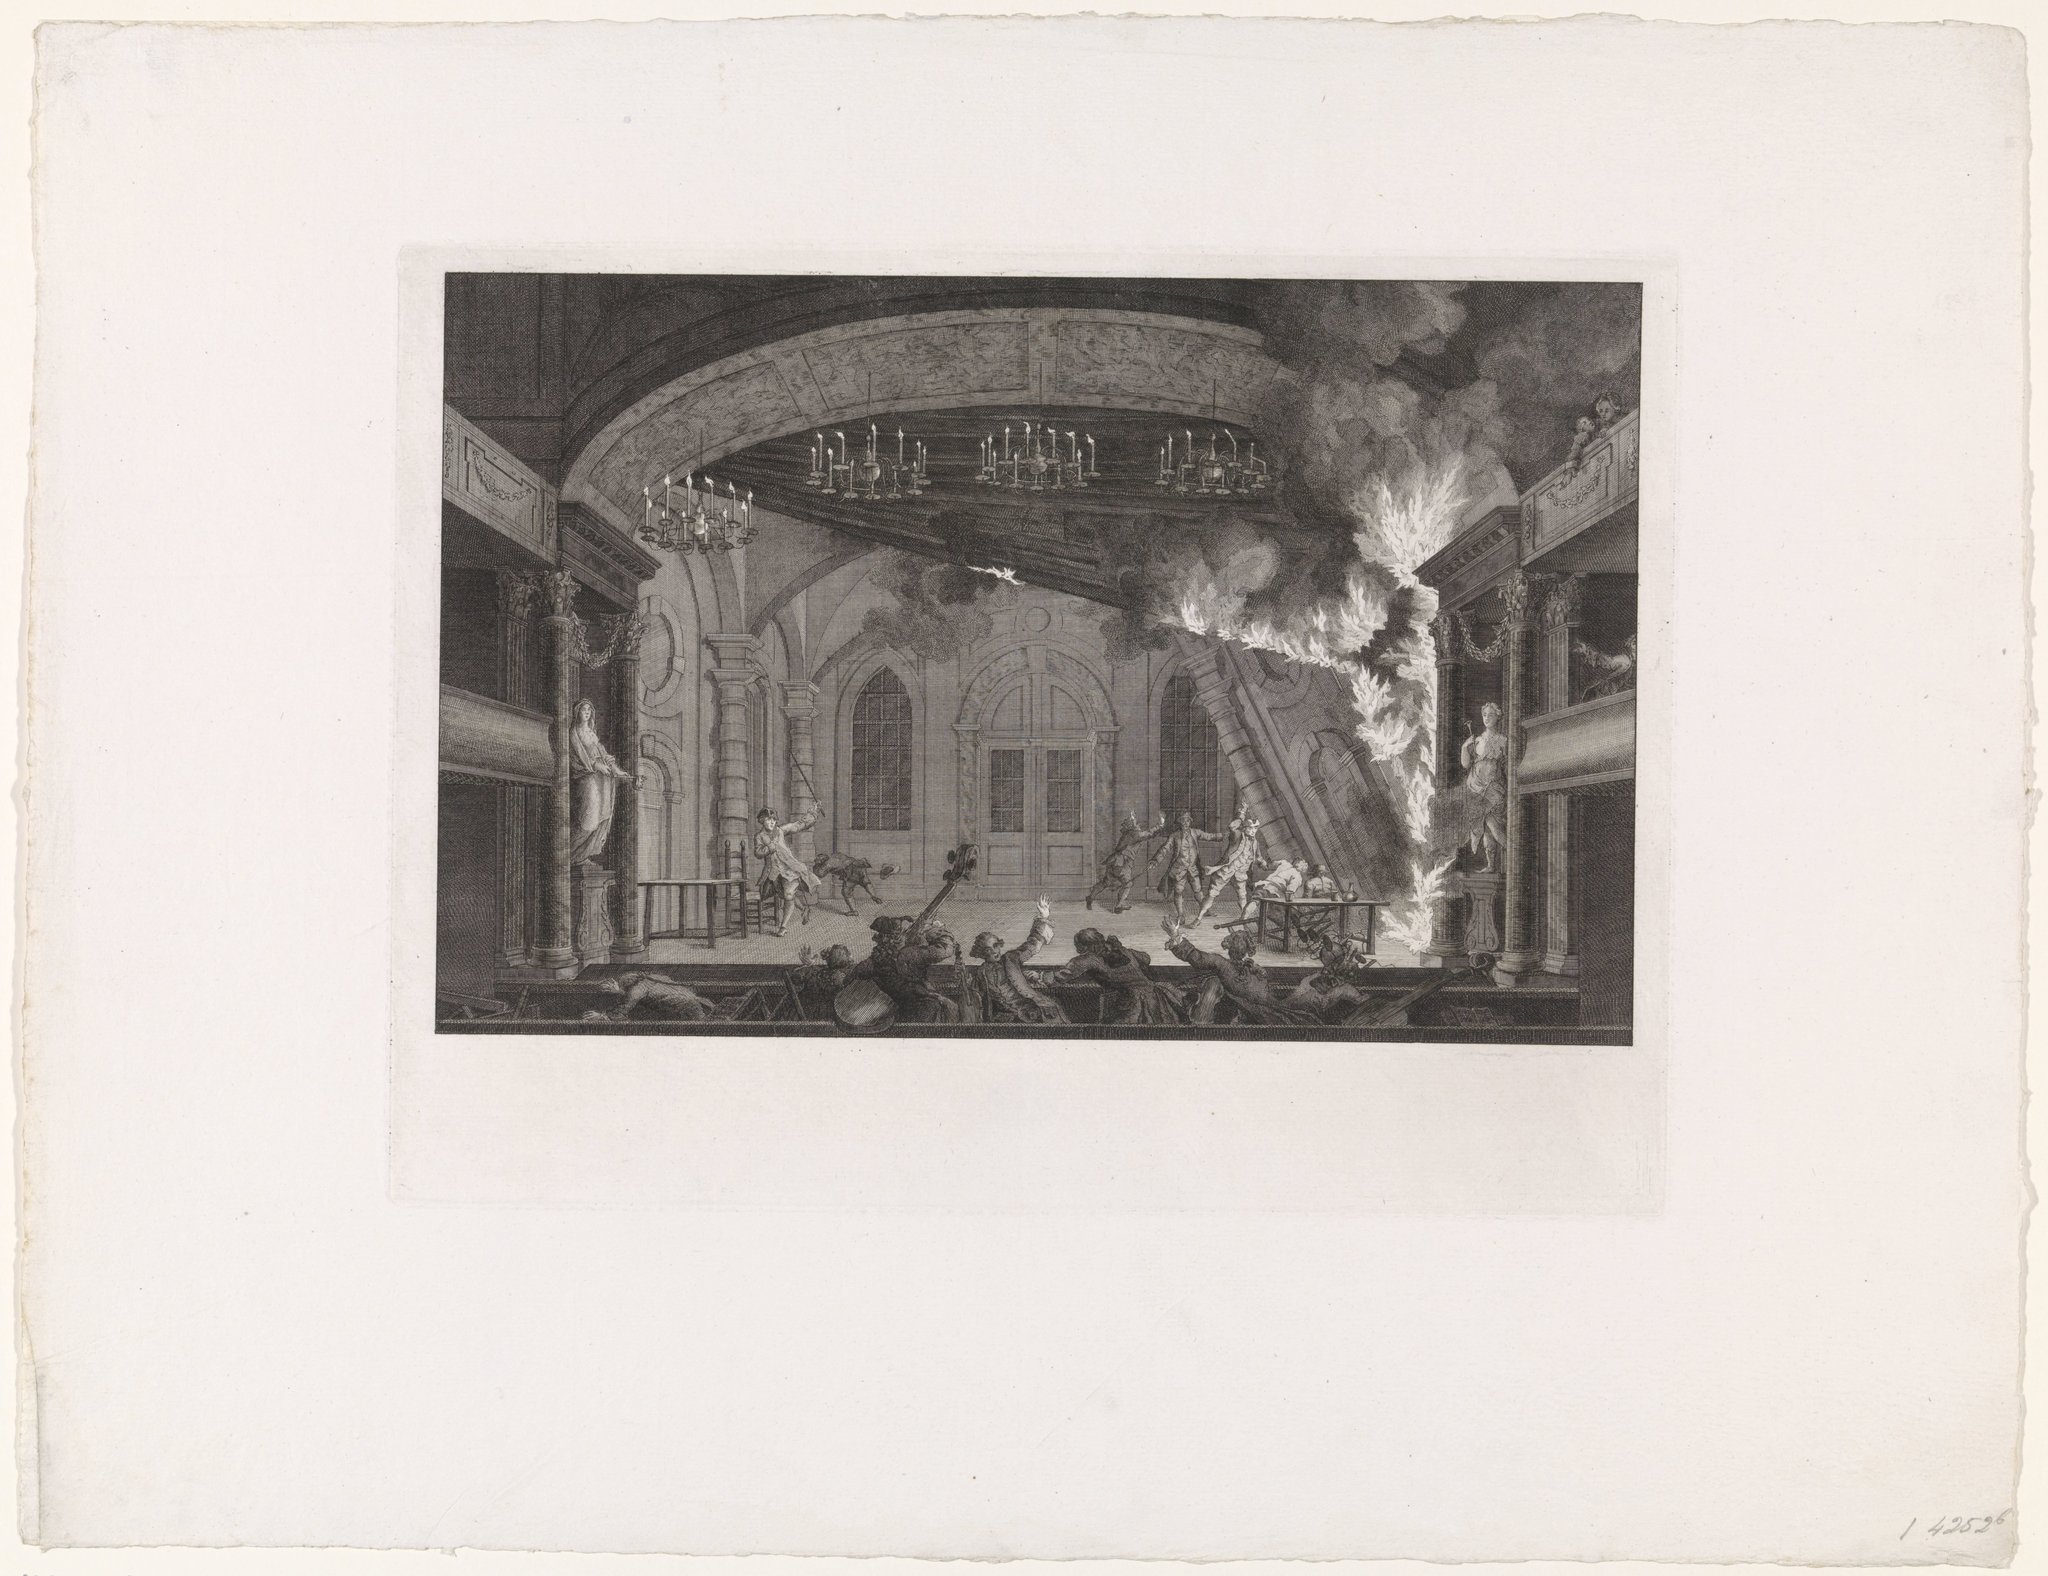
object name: print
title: De brand in de Amsterdamse Schouwburg, 1772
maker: cornelis bogerts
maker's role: print maker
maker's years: 1745-1817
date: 1772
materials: paper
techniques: engraving, etching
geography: northern netherlands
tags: on fire, ablaze, theatre, theatrical performance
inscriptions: collector's mark: Lugt 2228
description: Gezicht op het toneel met het uitbreken van de brand in de Amsterdamse Schouwburg tijdens de voorstelling op 11 mei 1772. Leden van het orkest vluchten weg uit de orkestbak. Onderdeel van een serie van vier prenten met titelprent over de brand in de Amsterdamse Schouwburg.